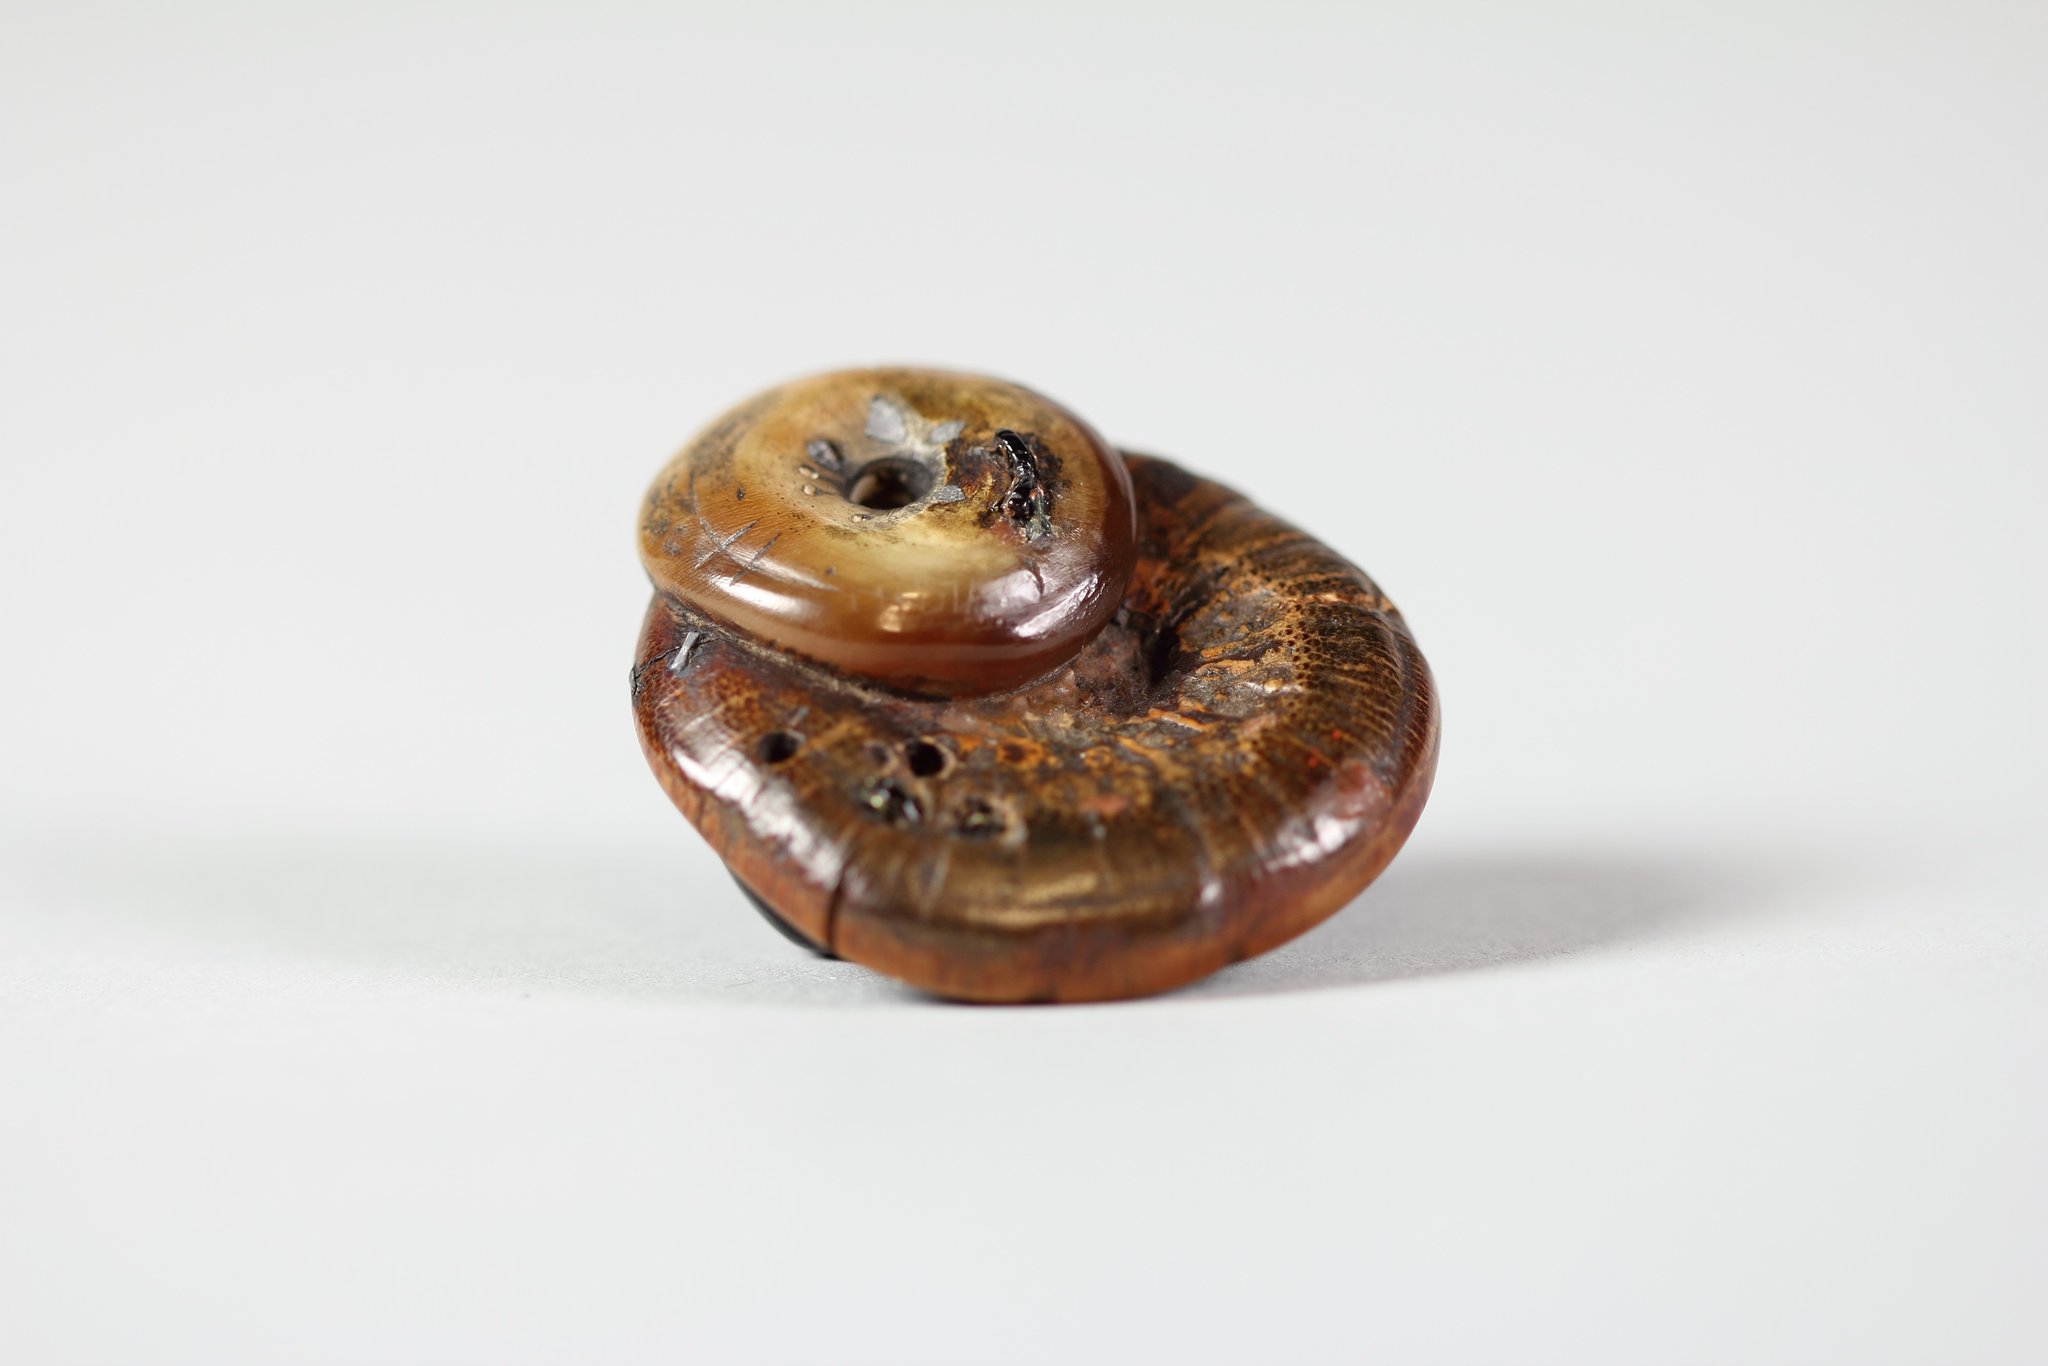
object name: netsuke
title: Netsuke of Mushroom Eaten by Insects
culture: japanese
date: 1701-1800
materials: horn, metal, wood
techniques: inlay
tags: insects